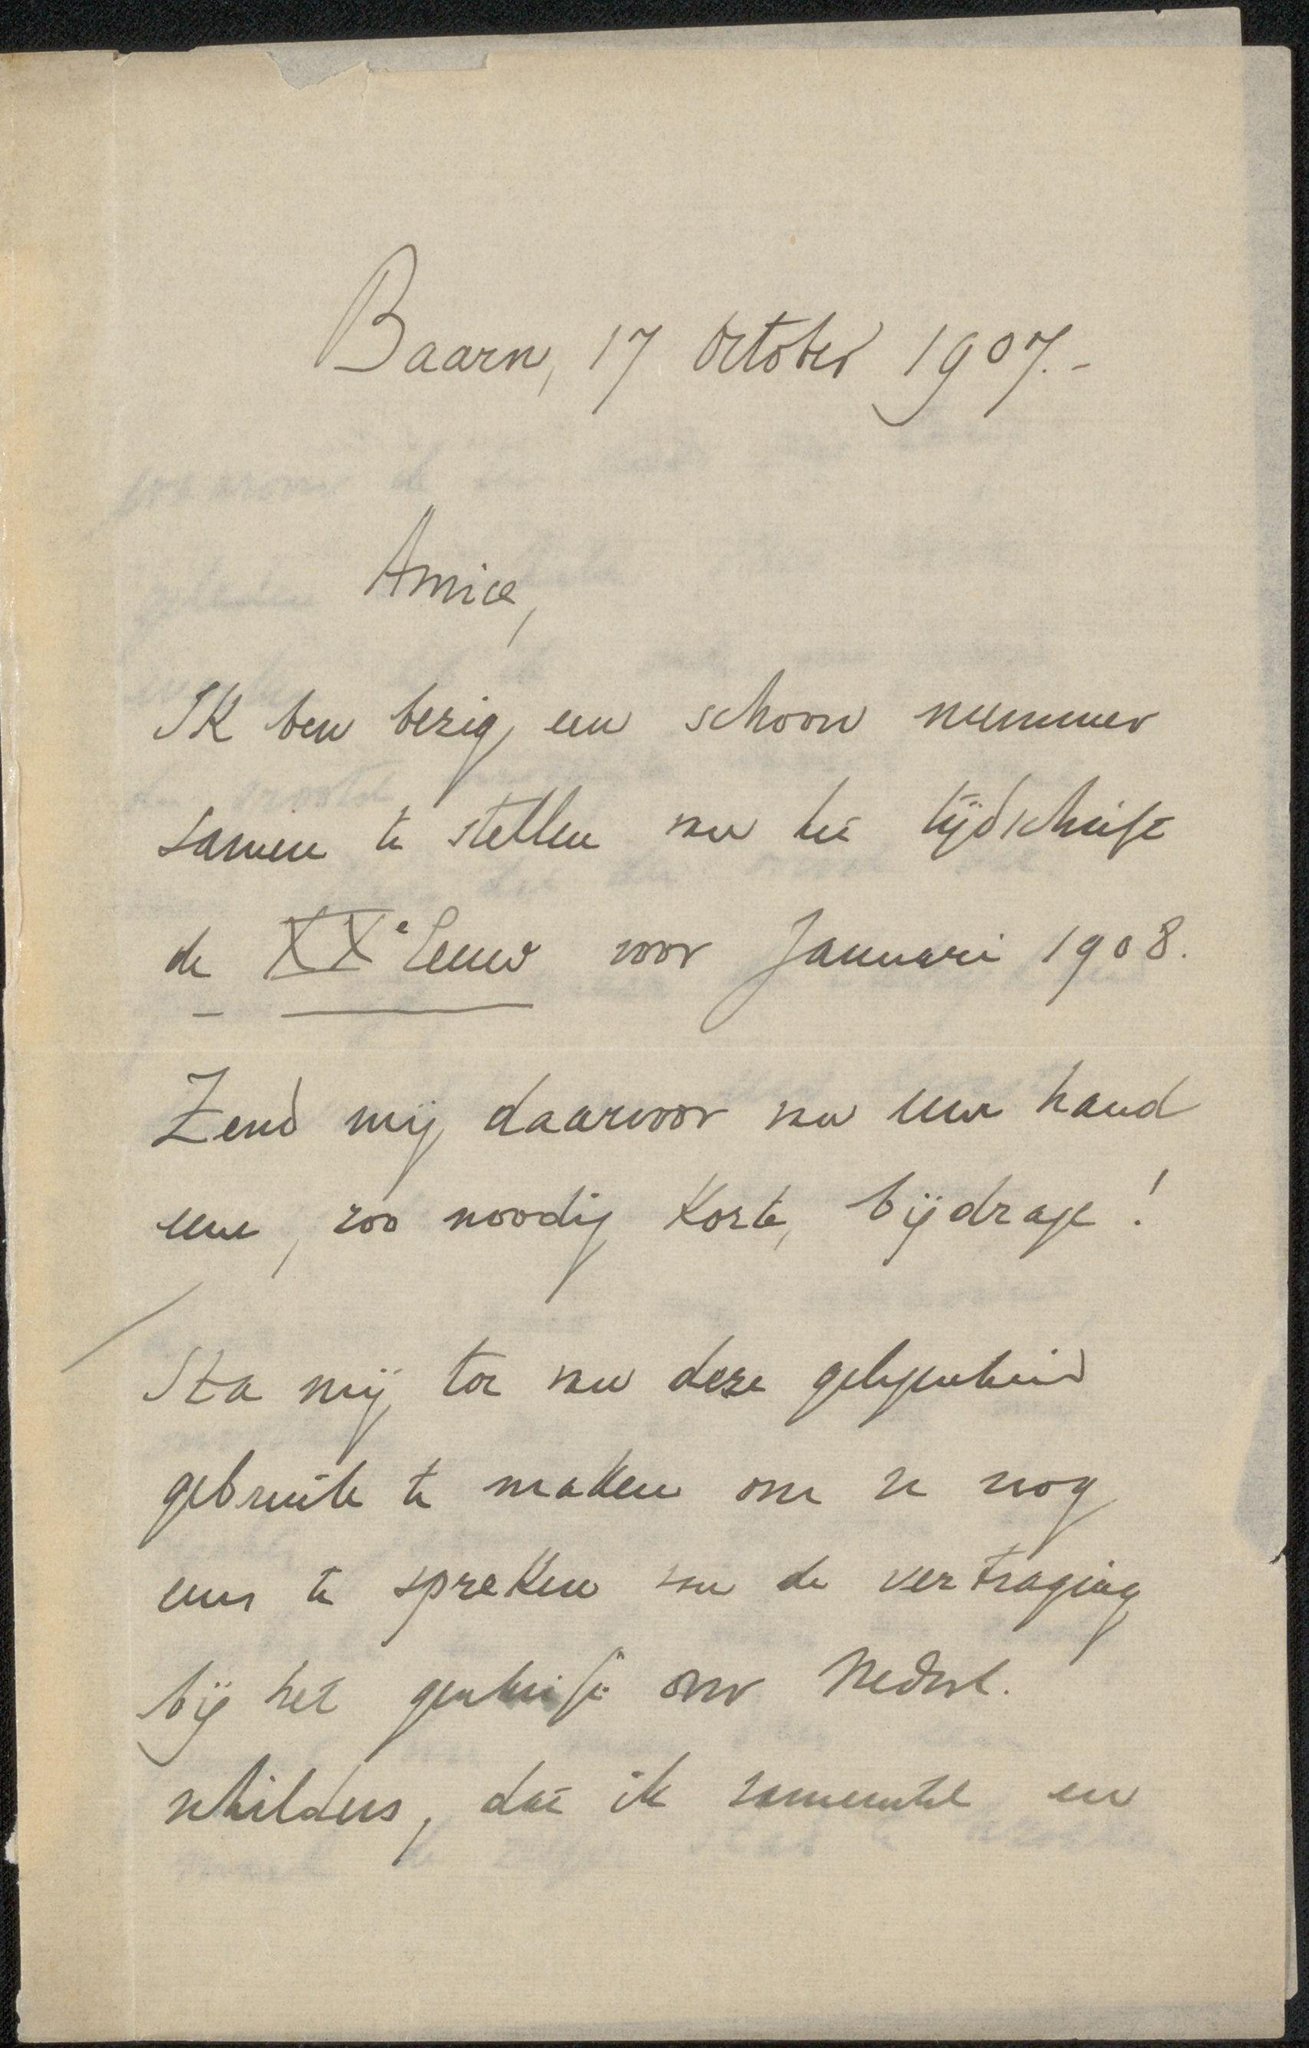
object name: letter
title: Brief aan Jan Veth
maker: karel johan lodewijk alberdingk thijm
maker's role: criticus, prozaschrijver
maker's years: 1864-1952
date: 1907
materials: ink, paper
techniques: pen, writing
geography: baarn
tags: dordrecht, painter, print maker, draughtsman, designer, jan veth, painting (including book-illumination, miniature-painting)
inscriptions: collector's mark: ‘RPK’